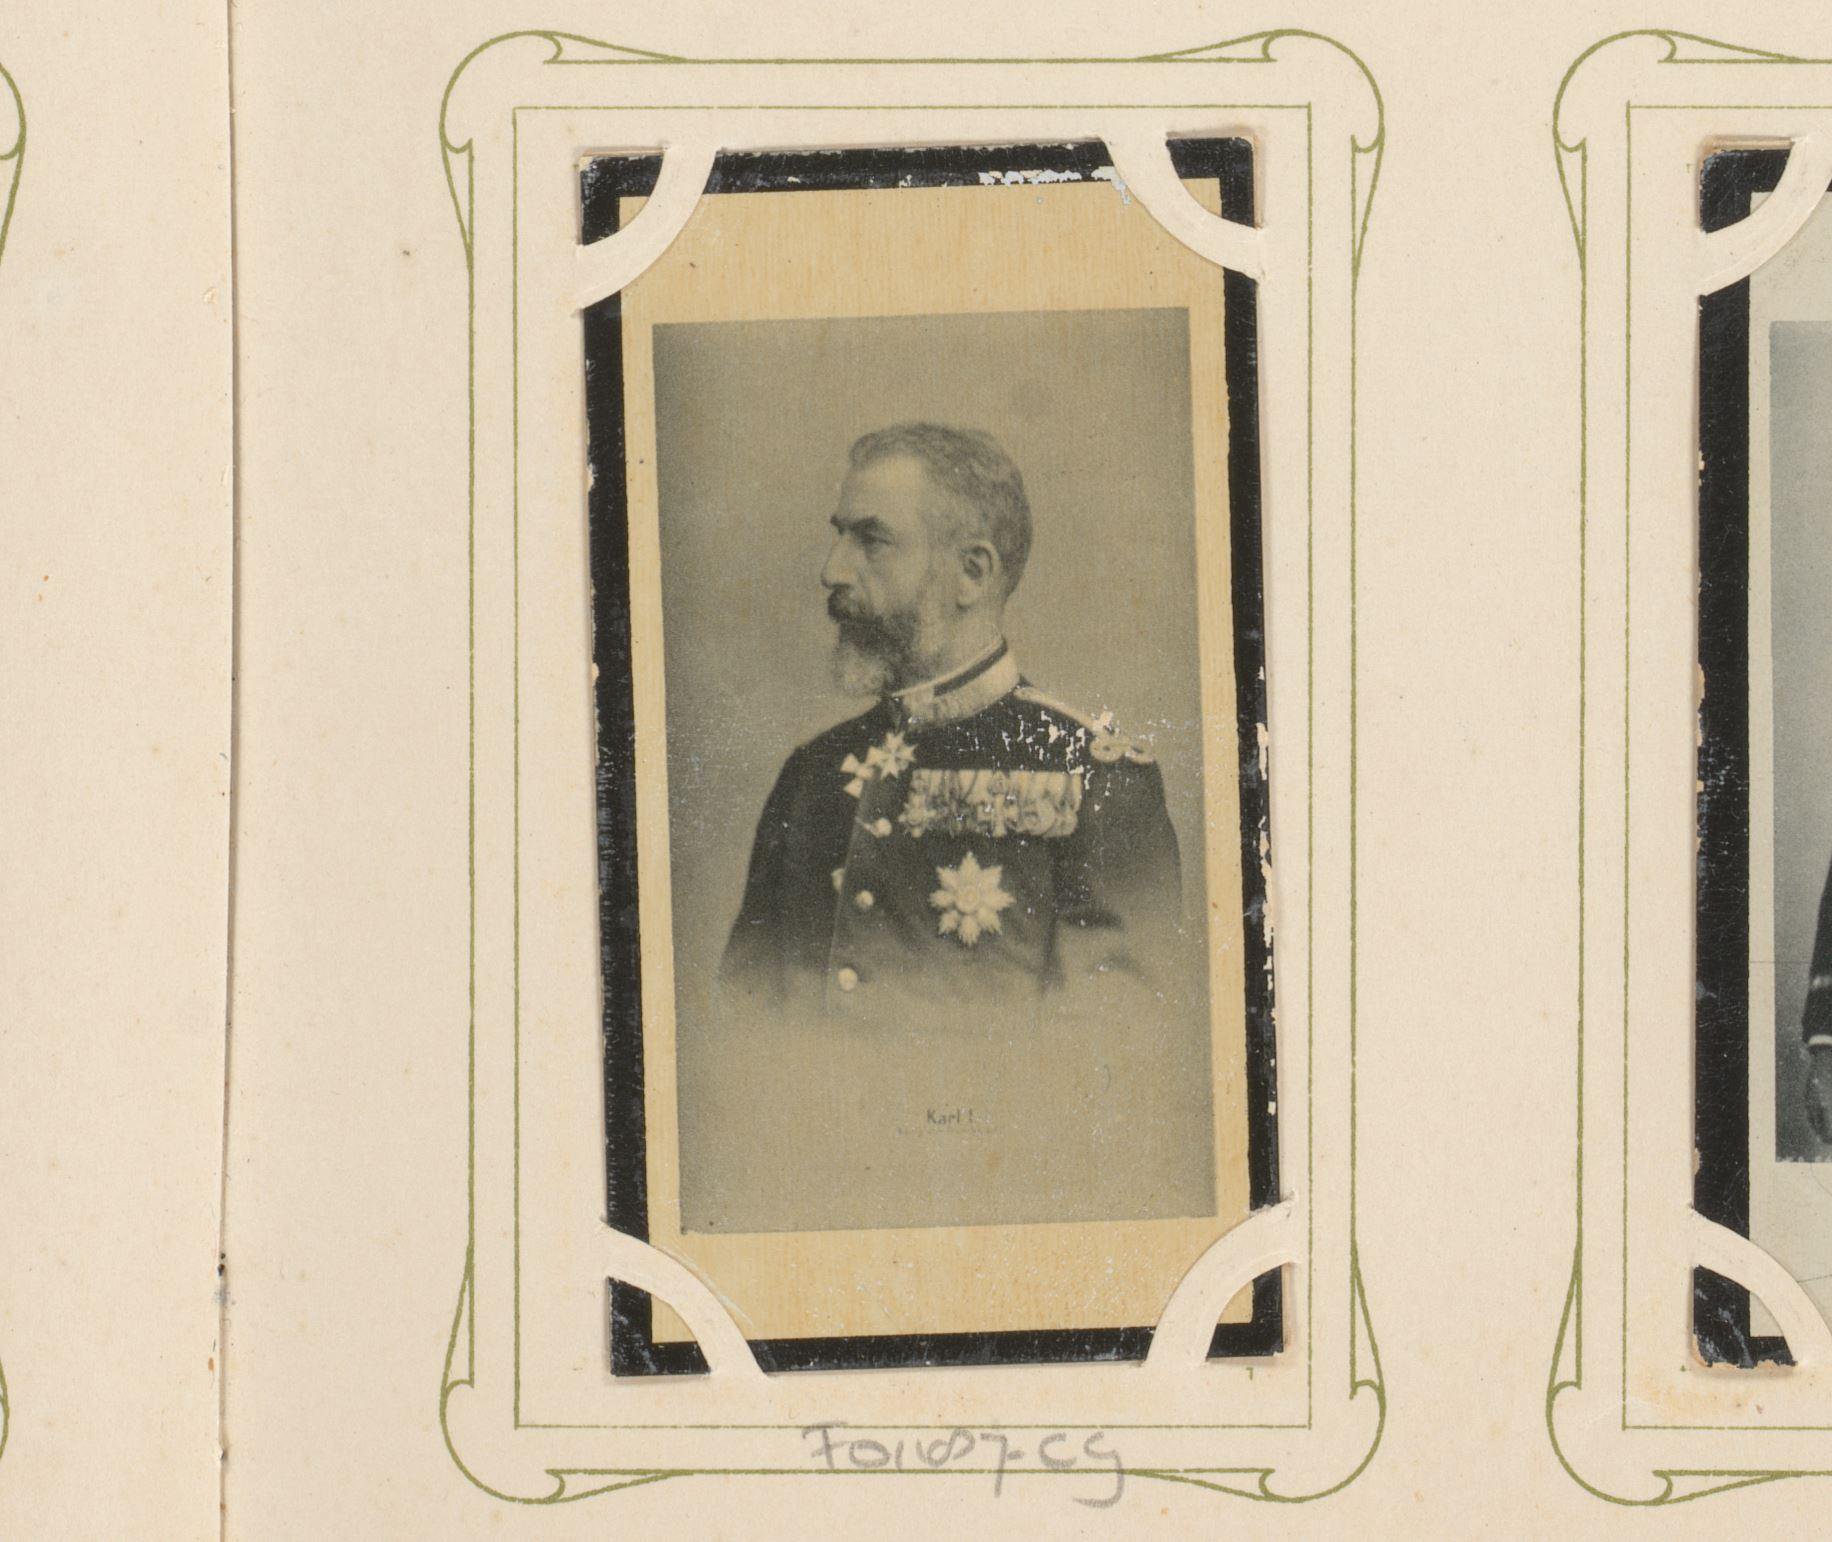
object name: album leaf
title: Portret van koning Carol I van Roemenië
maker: Anonymous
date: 1905-1906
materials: paper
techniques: photograph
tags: historical persons, king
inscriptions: inscription: ‘No. 10./ Koning Karel I van Rumenië.’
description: Deze prent maakt deel uit van een album.